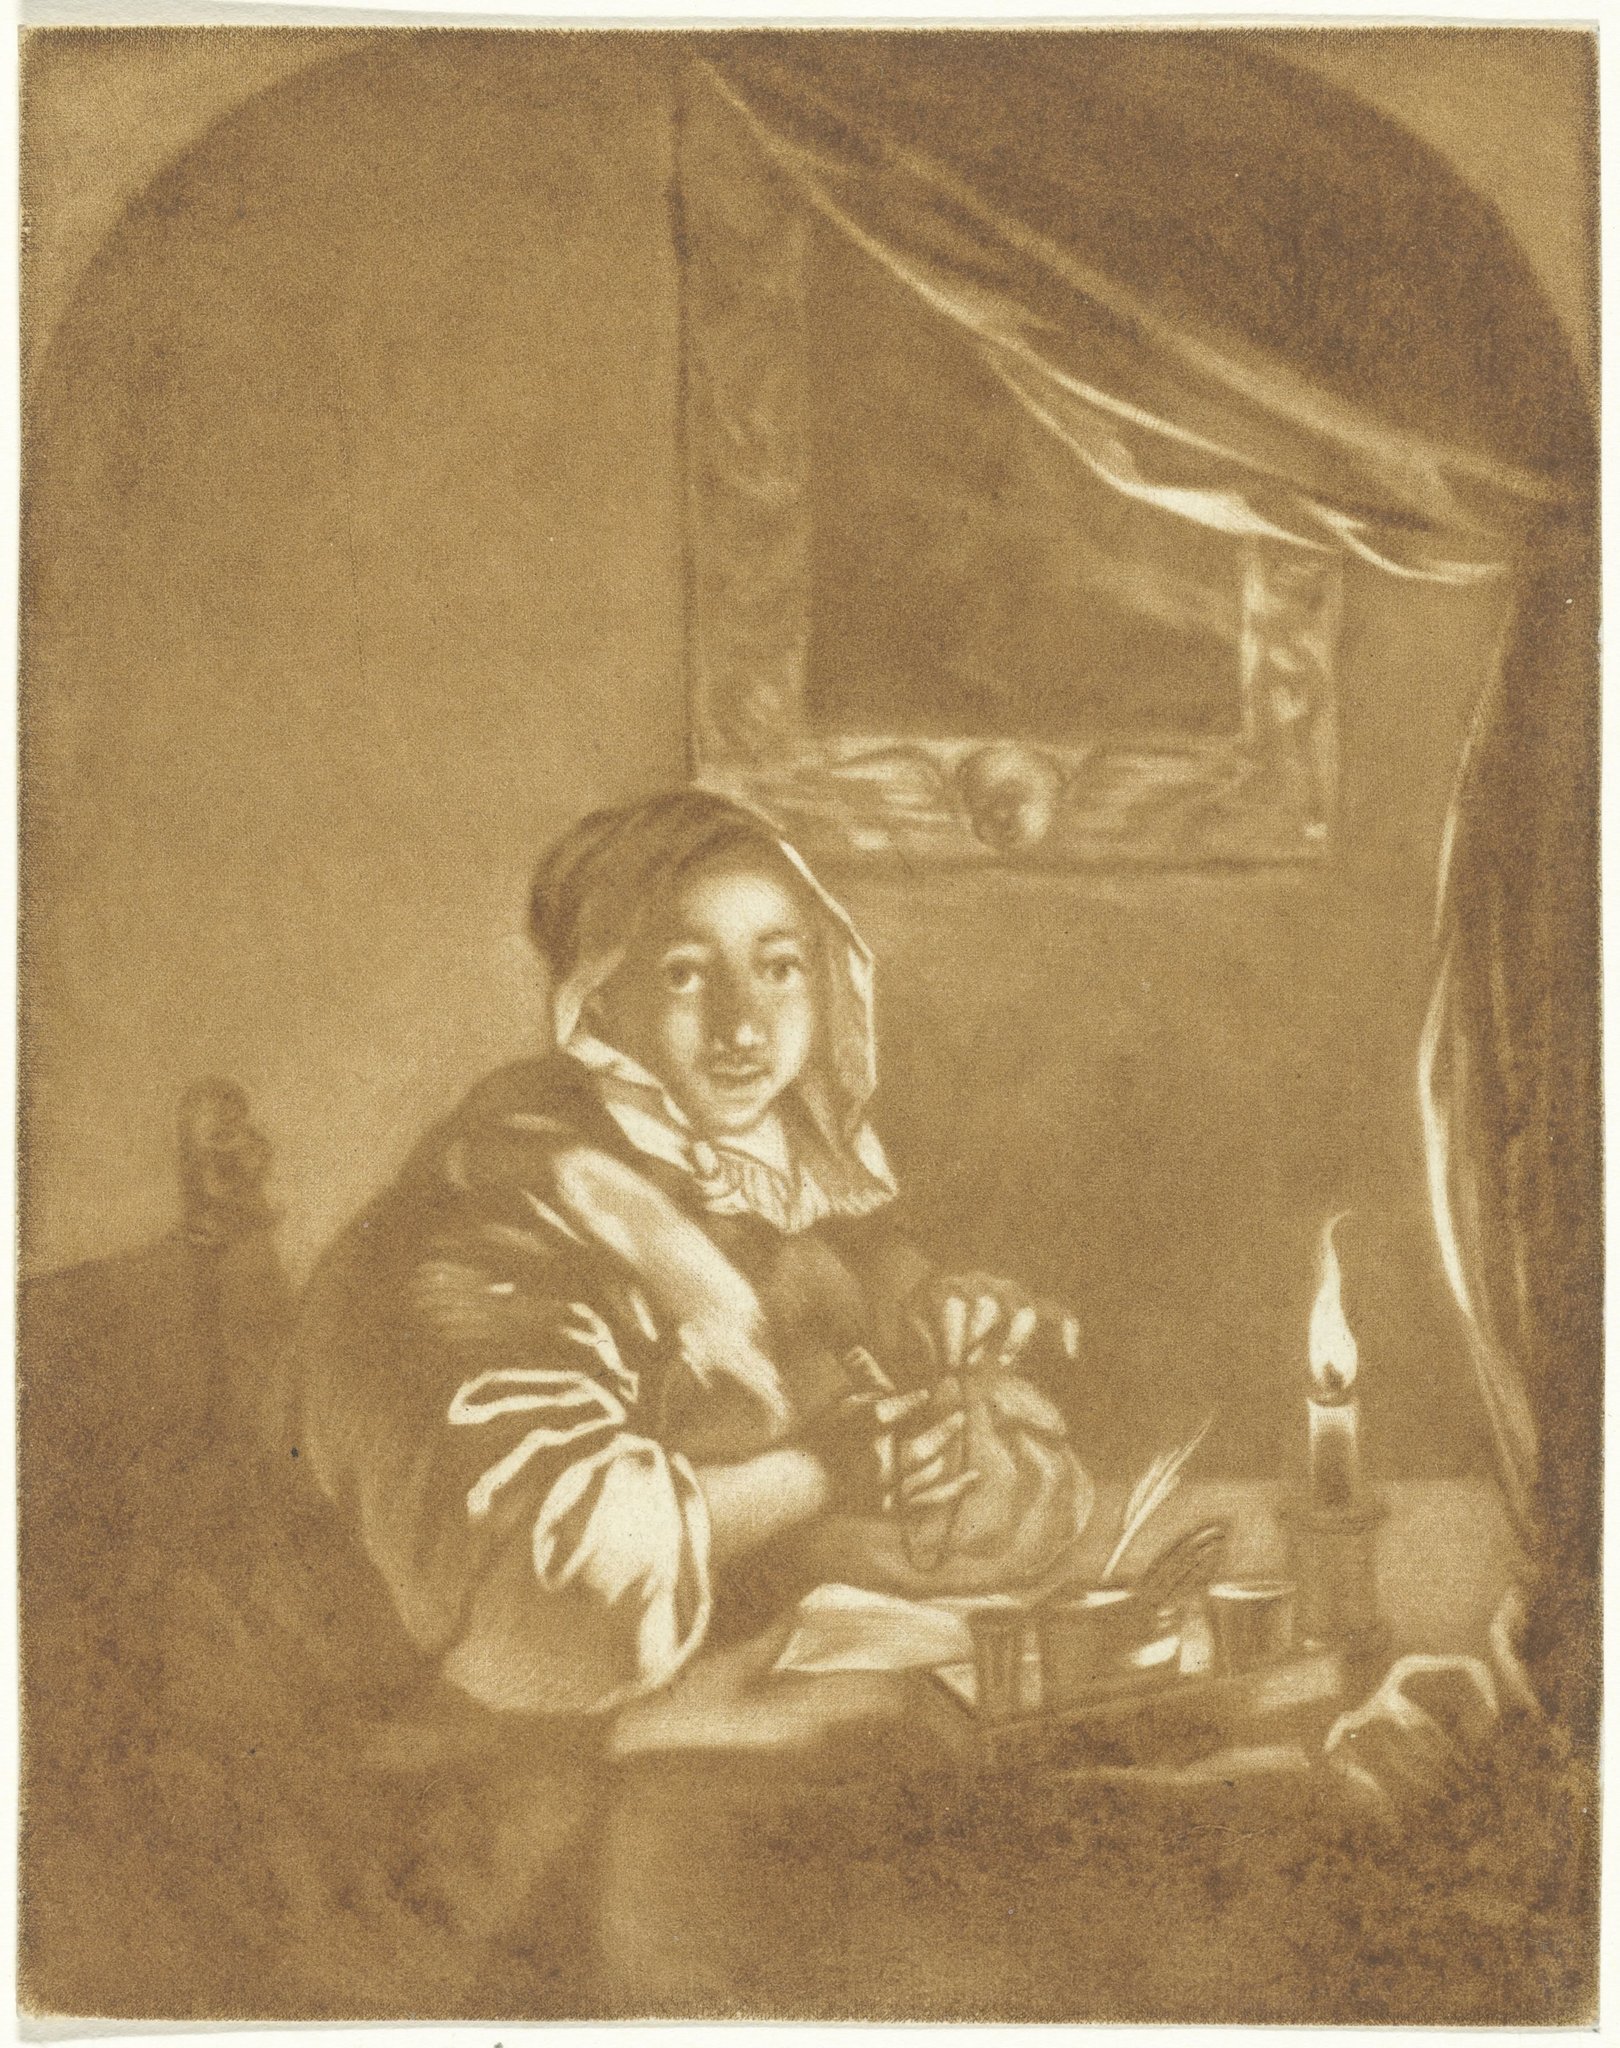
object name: print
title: Dame bij kaarslicht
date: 1736-1798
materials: paper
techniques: etching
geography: amsterdam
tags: candle, (other forms of) needlework, e.g.: crocheting, knitting, embroidering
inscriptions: collector's mark: Lugt 2725, collector's mark: Lugt 240, inscription: ‘Gasp Netscher del Ploos v Amstel f’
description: Een vrouw, zittend aan tafel met een breiwerk in de handen, bij kaarslicht.